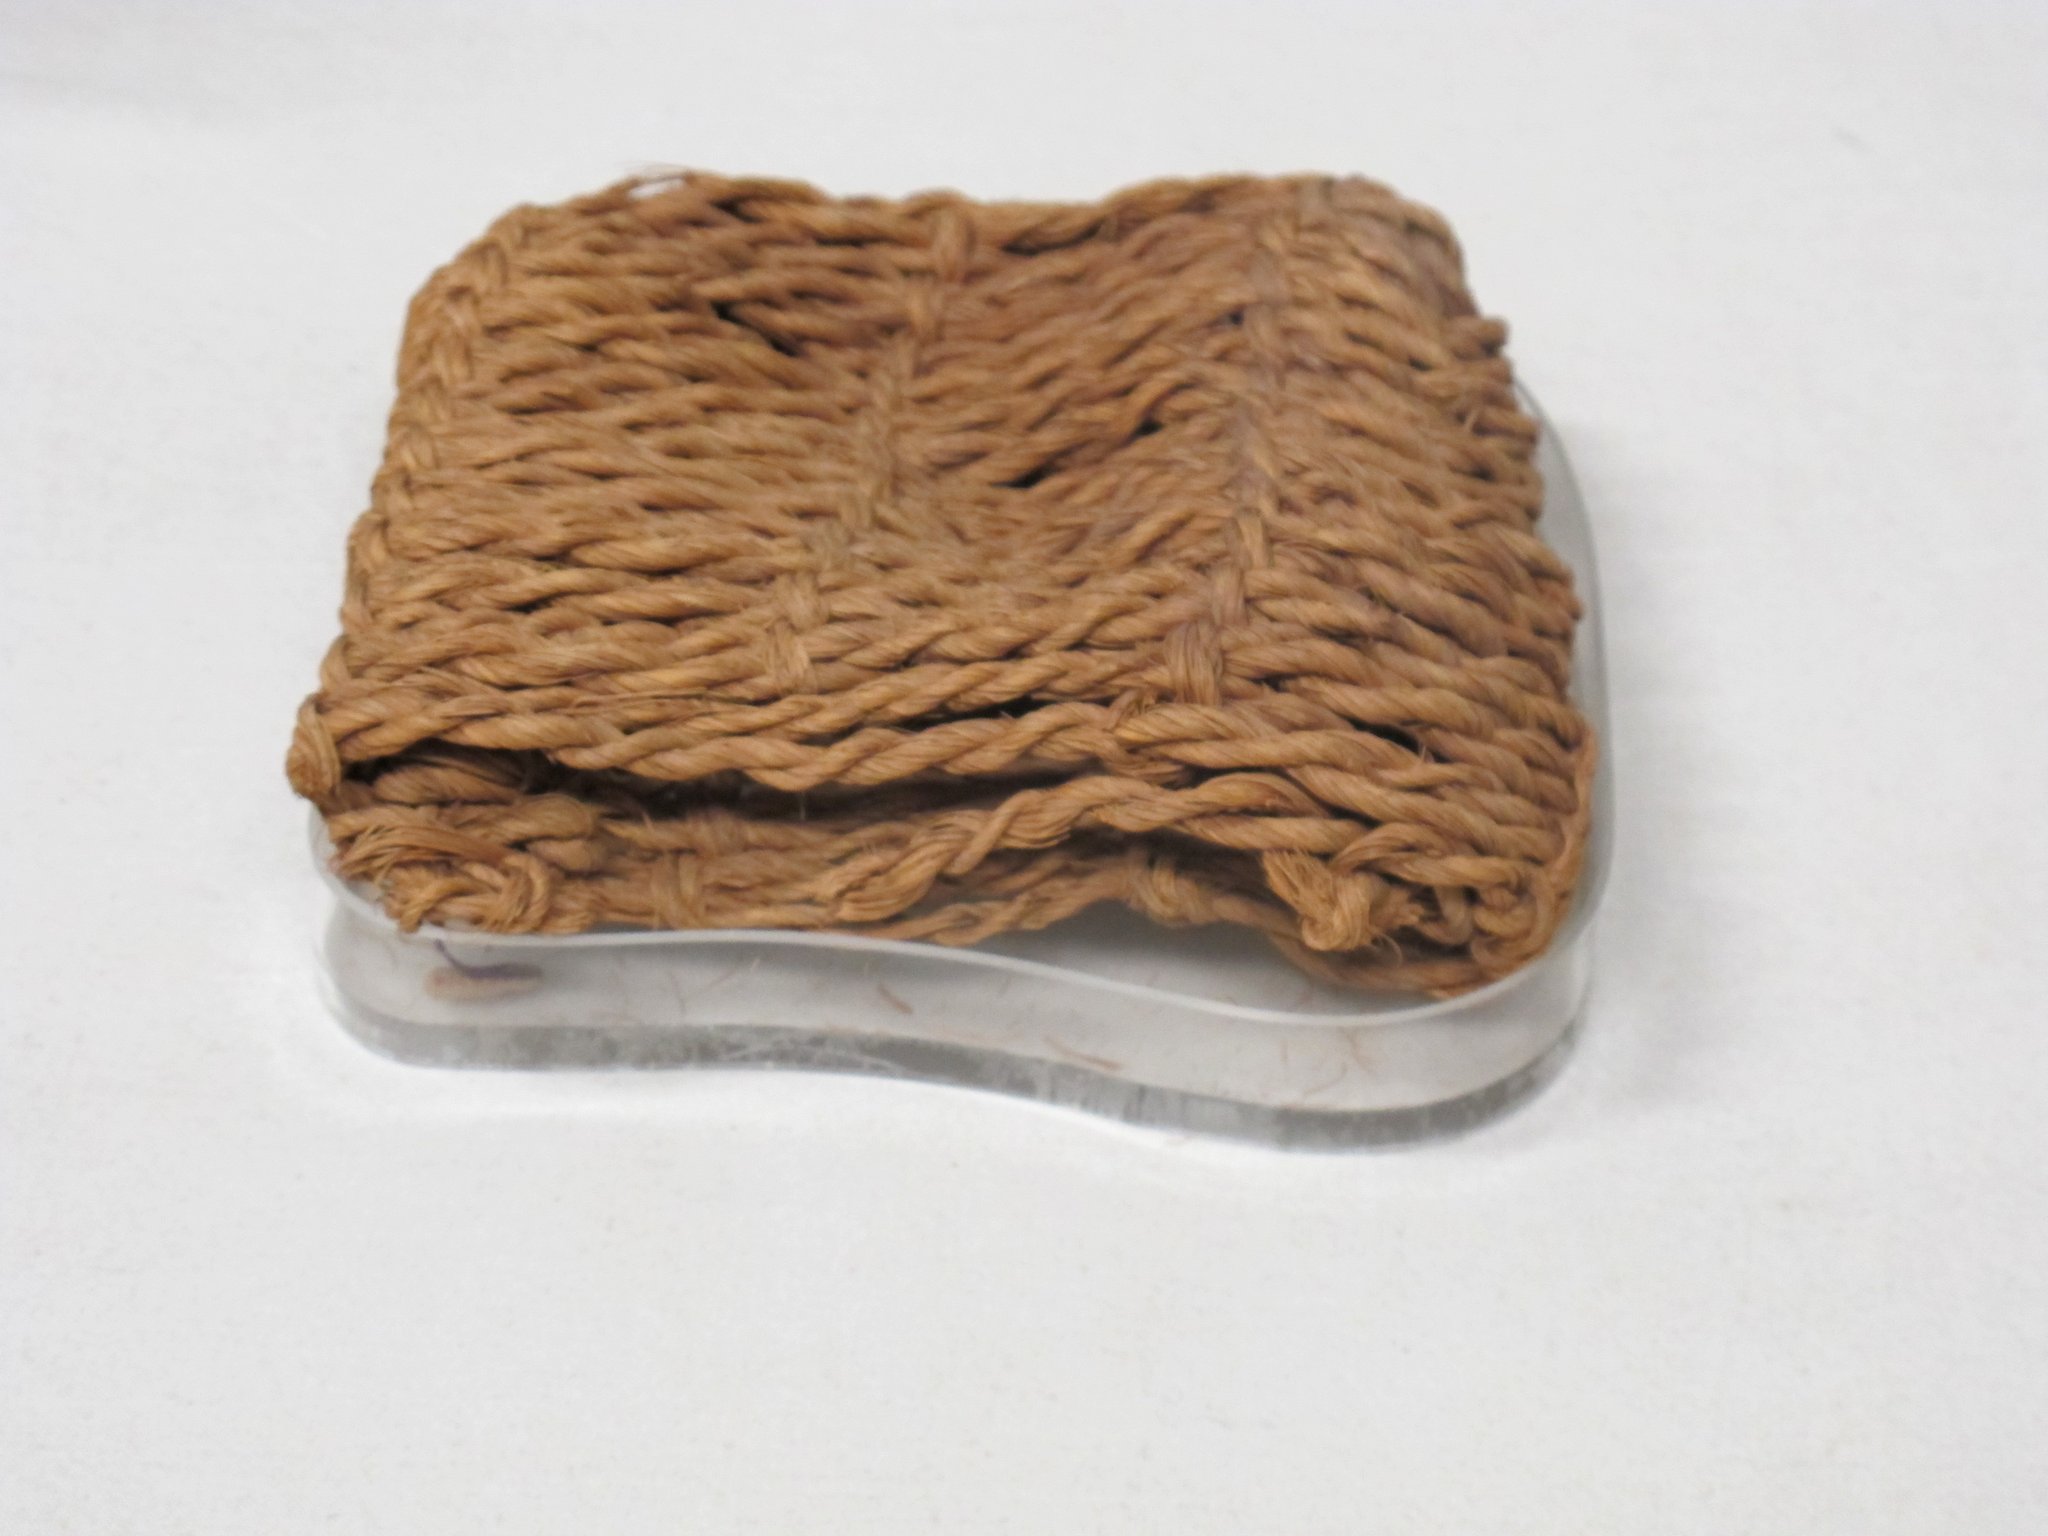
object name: model donkey bag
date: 2030-1640 BCE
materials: fiber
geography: egypt